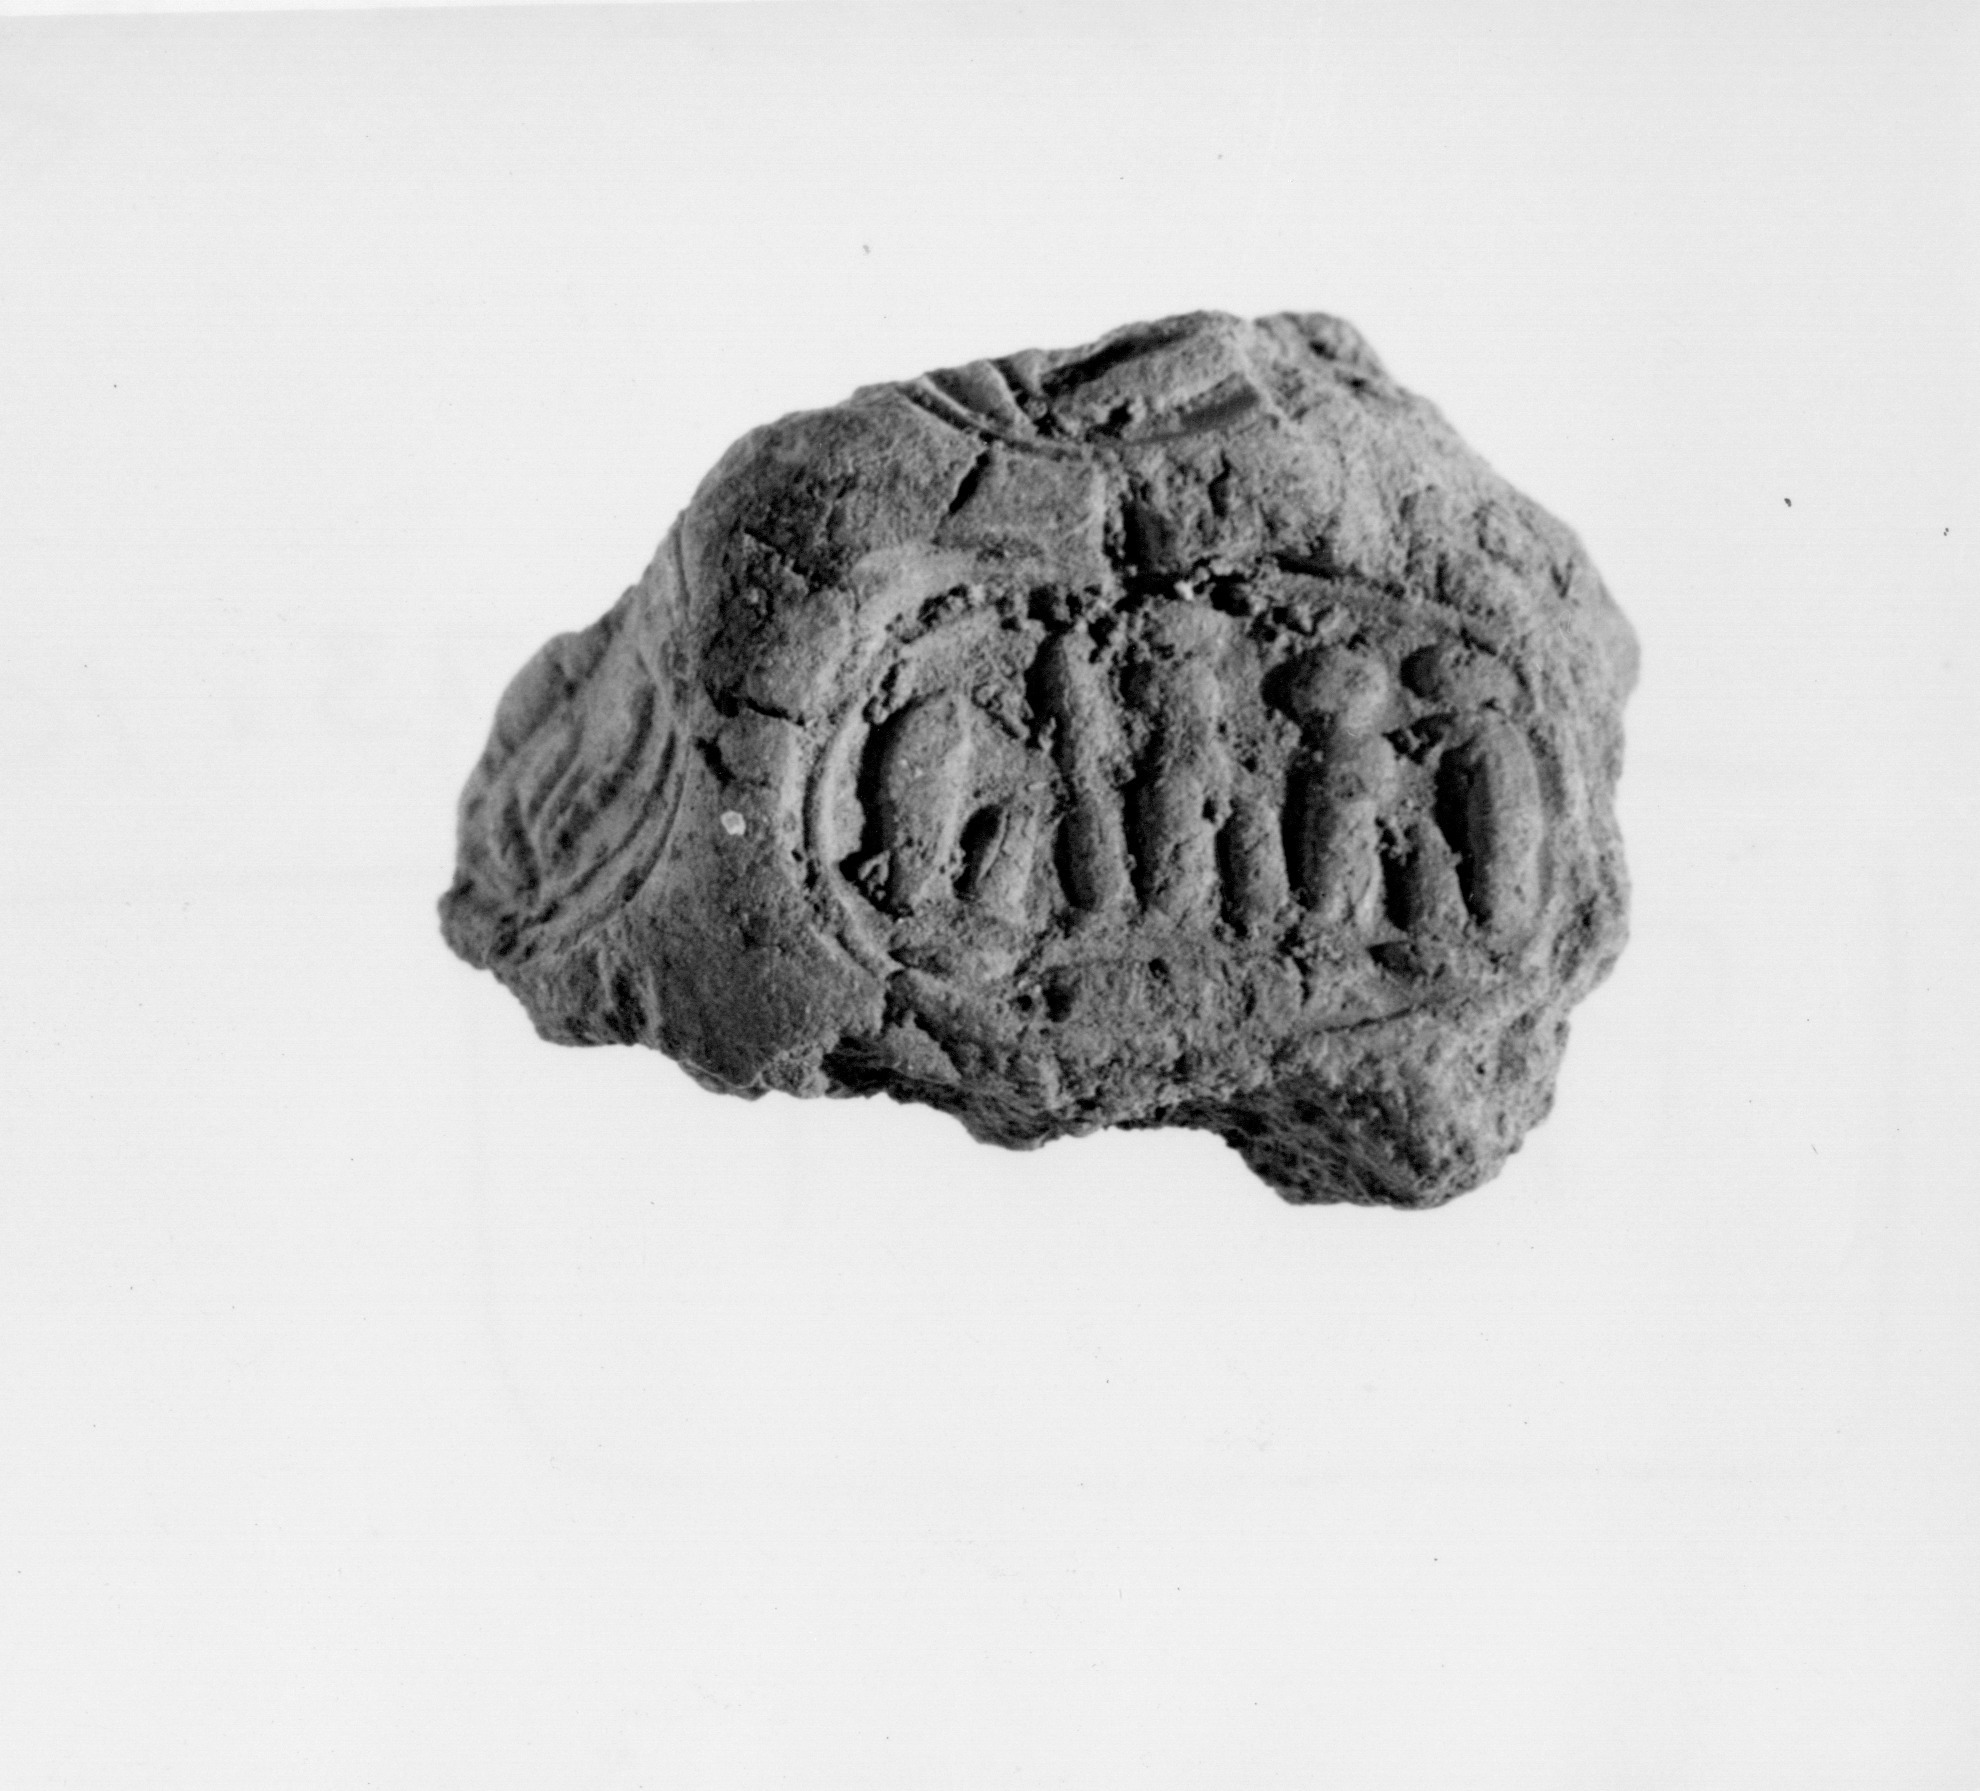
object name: sealing, nebmaatre, amenhotep iii, thoth, ptah, re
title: Document Sealing With the Throne Name of Amenhotep III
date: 1390-1352 BCE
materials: mud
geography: egypt